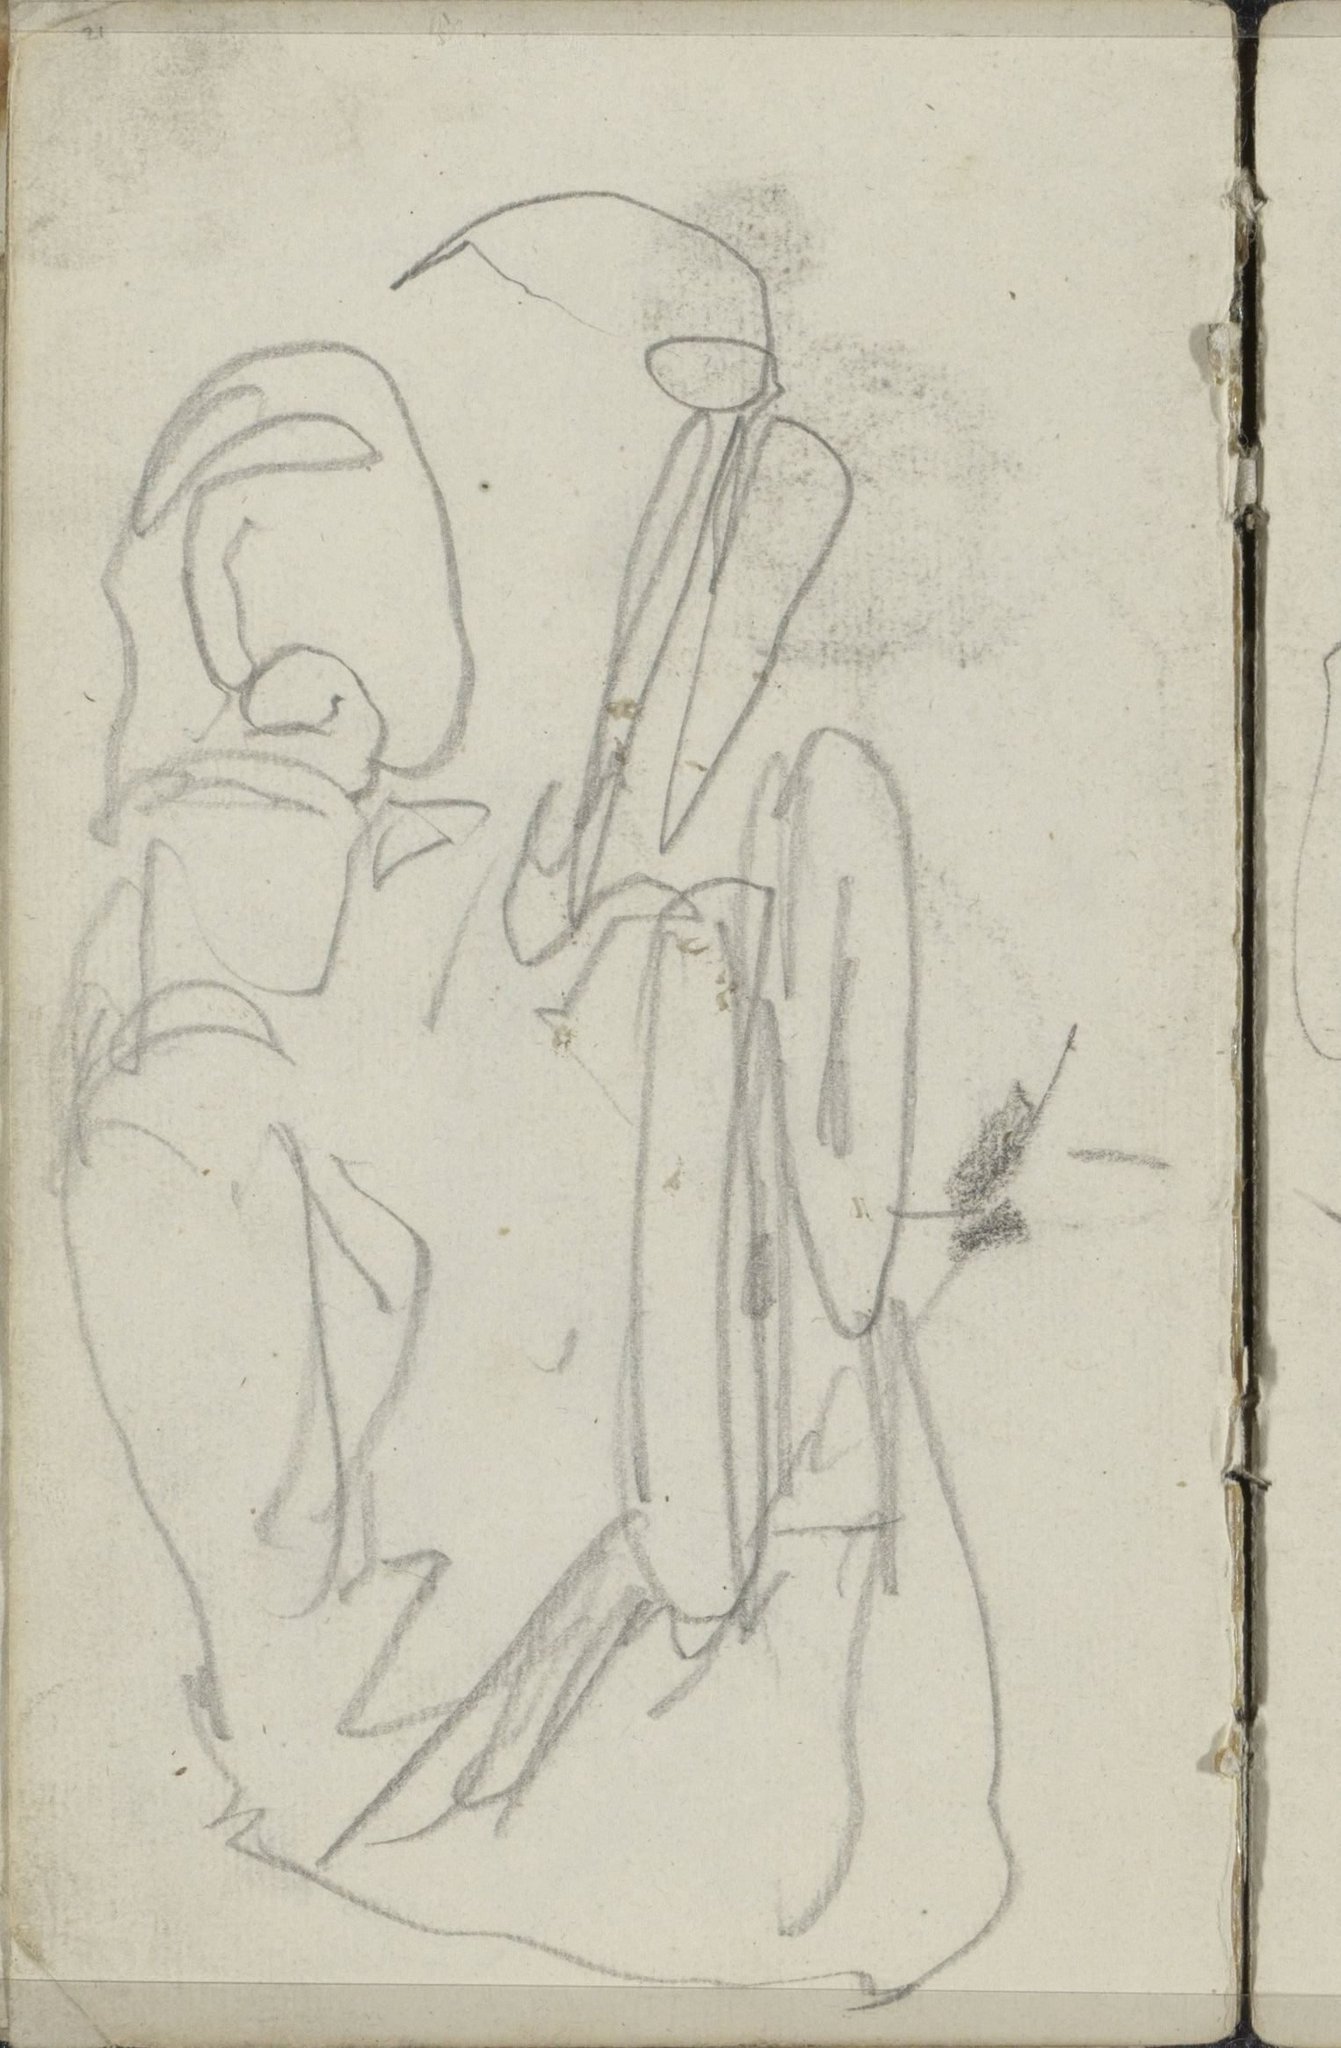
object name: sketchbook leaf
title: Figuurstudie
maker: george hendrik breitner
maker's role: draughtsman, painter, print maker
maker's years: 1857-1923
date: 1883-1885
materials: paper, pencil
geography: the hague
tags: adult woman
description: Pagina 21 uit een schetsboek met 17 bladen.